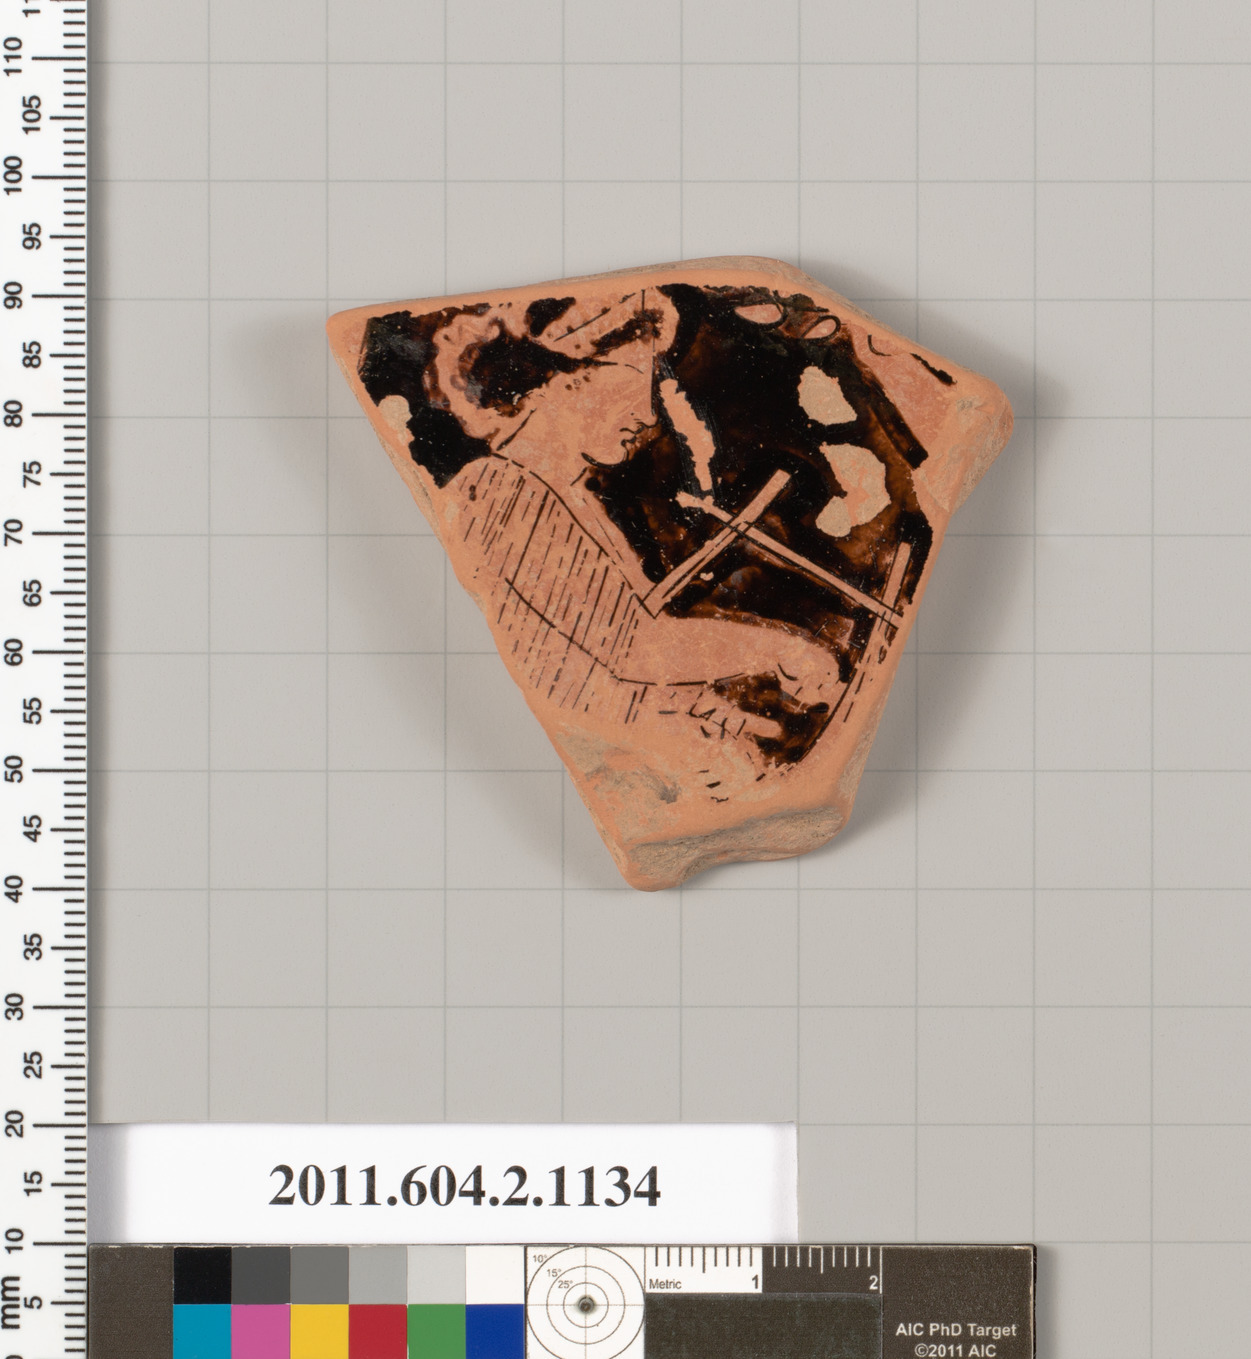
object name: lekanis fragment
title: Terracotta fragment of a lekanis lid (covered dish)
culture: greek, attic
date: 460-450 BCE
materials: terracotta